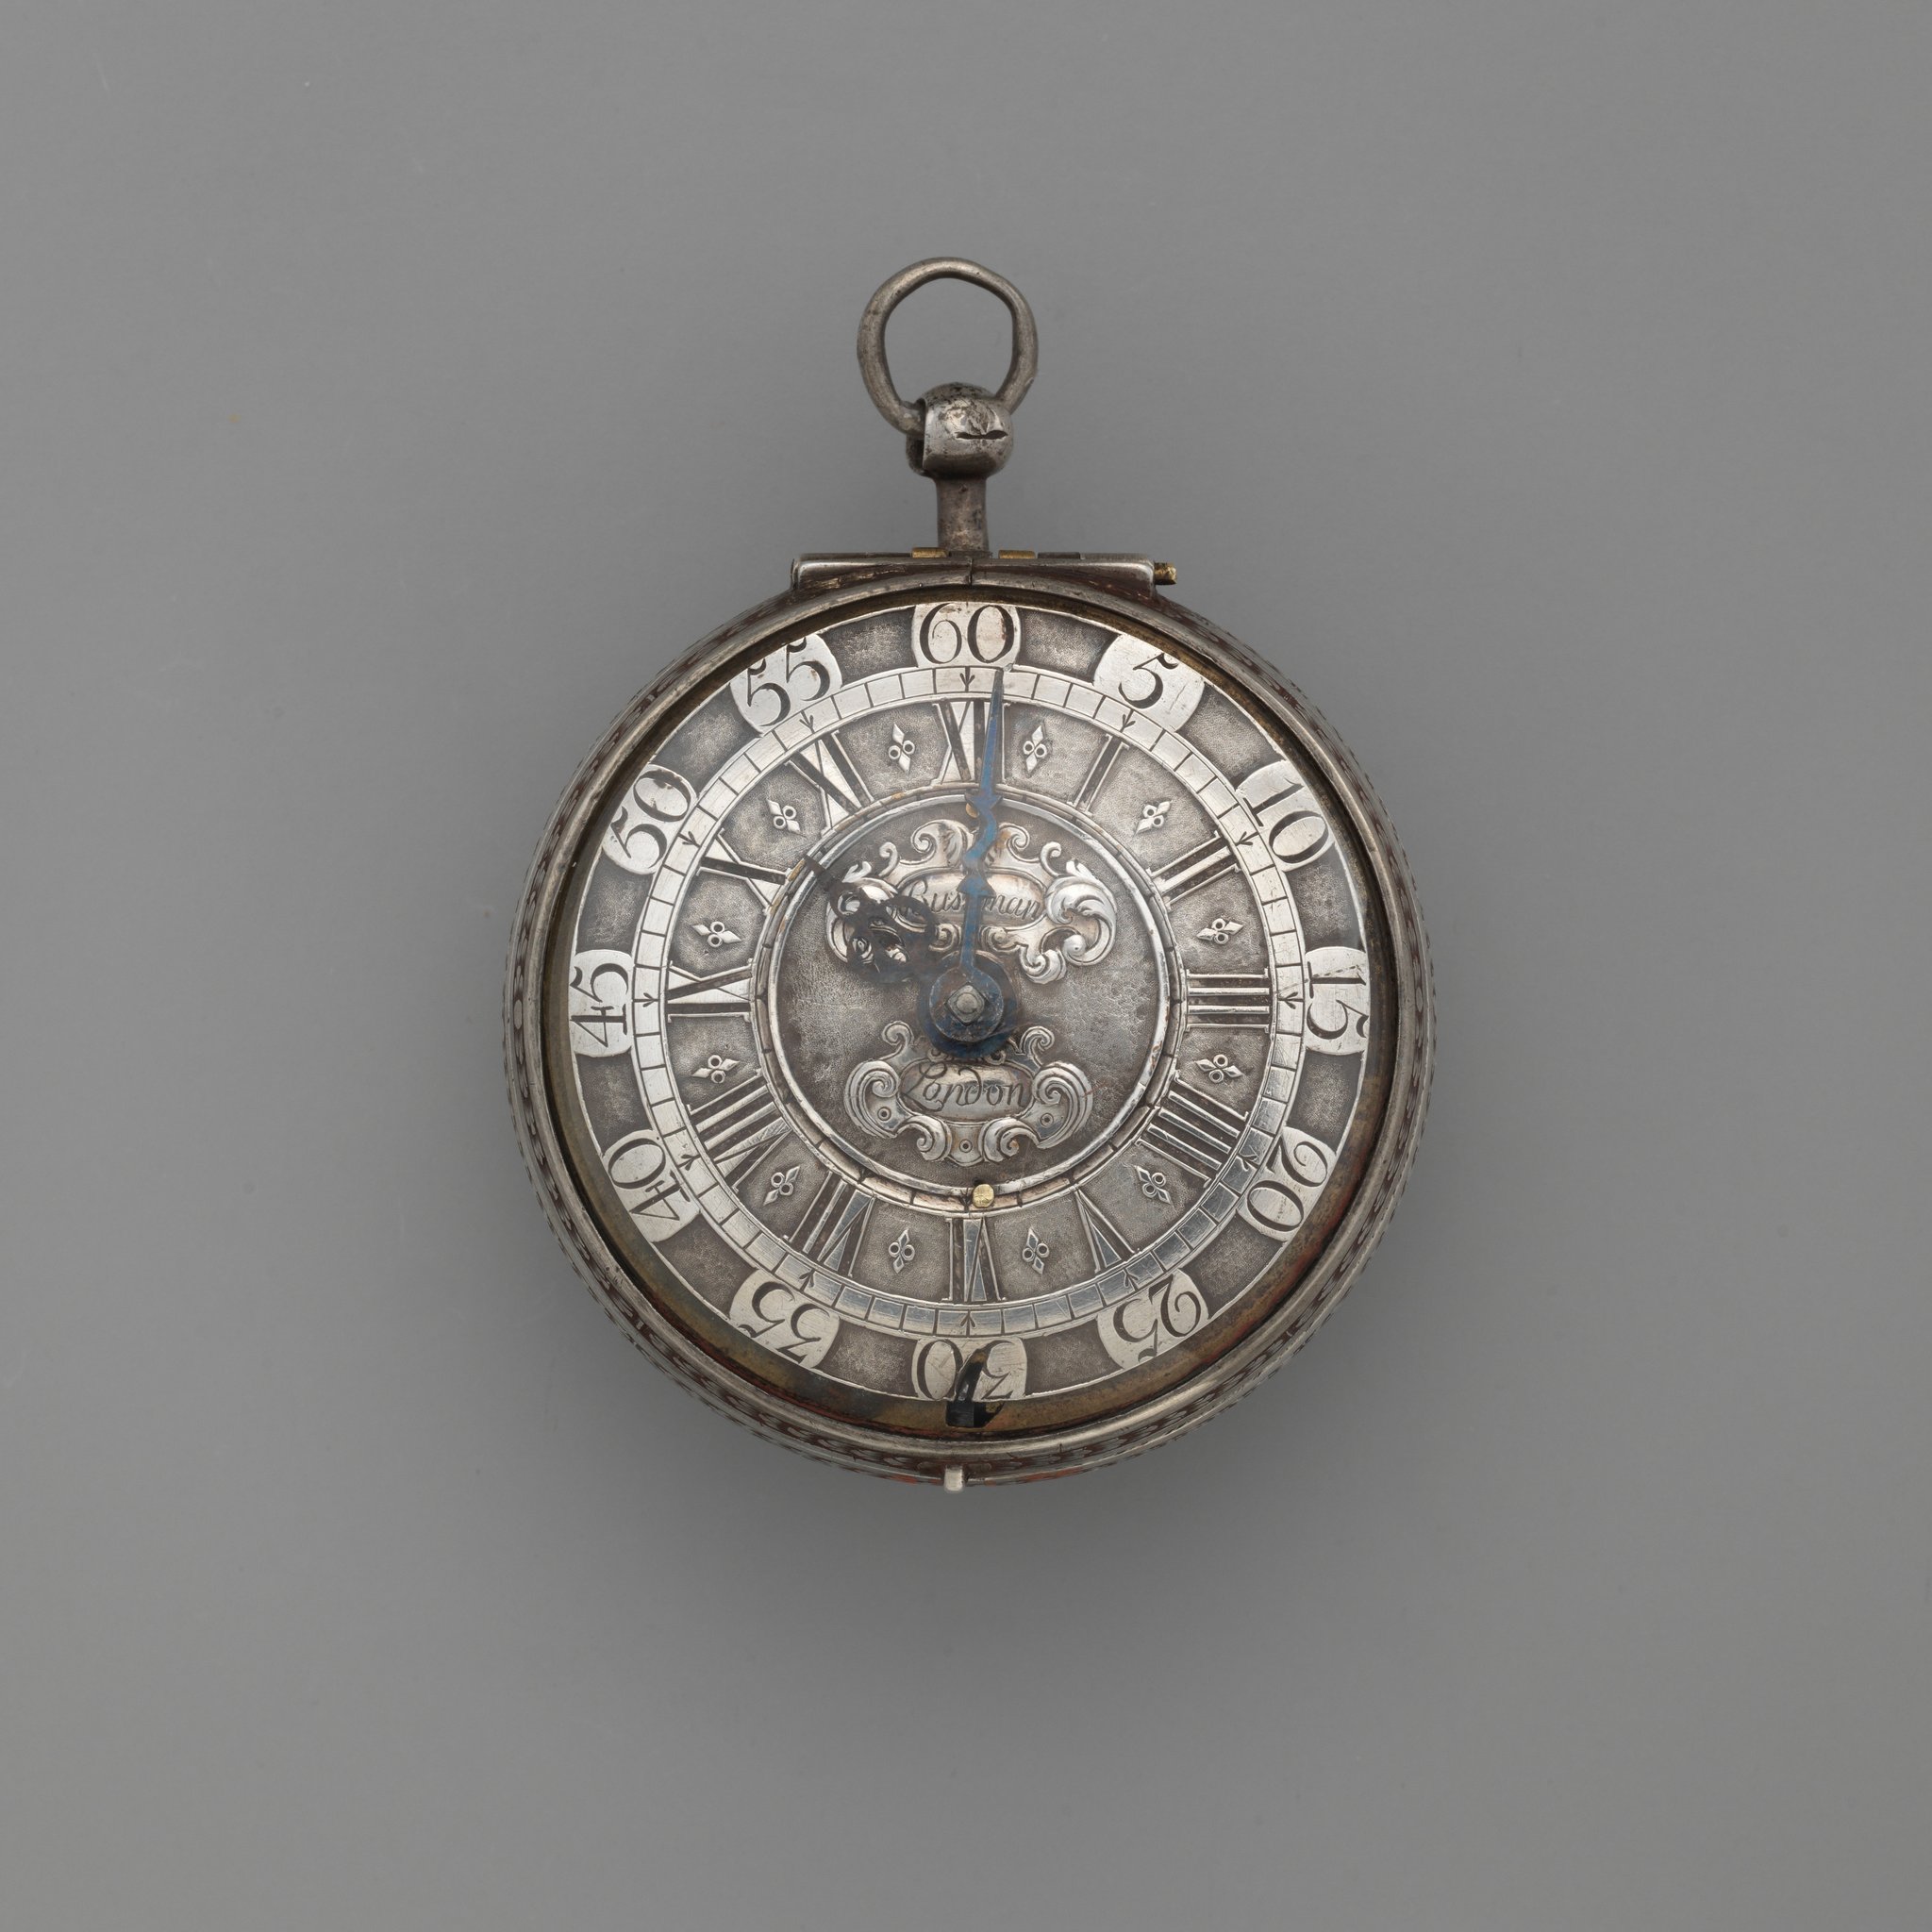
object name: watch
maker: john bushman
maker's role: maker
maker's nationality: british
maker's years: 1661-1710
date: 1601-1700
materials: niello, silver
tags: women,flowers